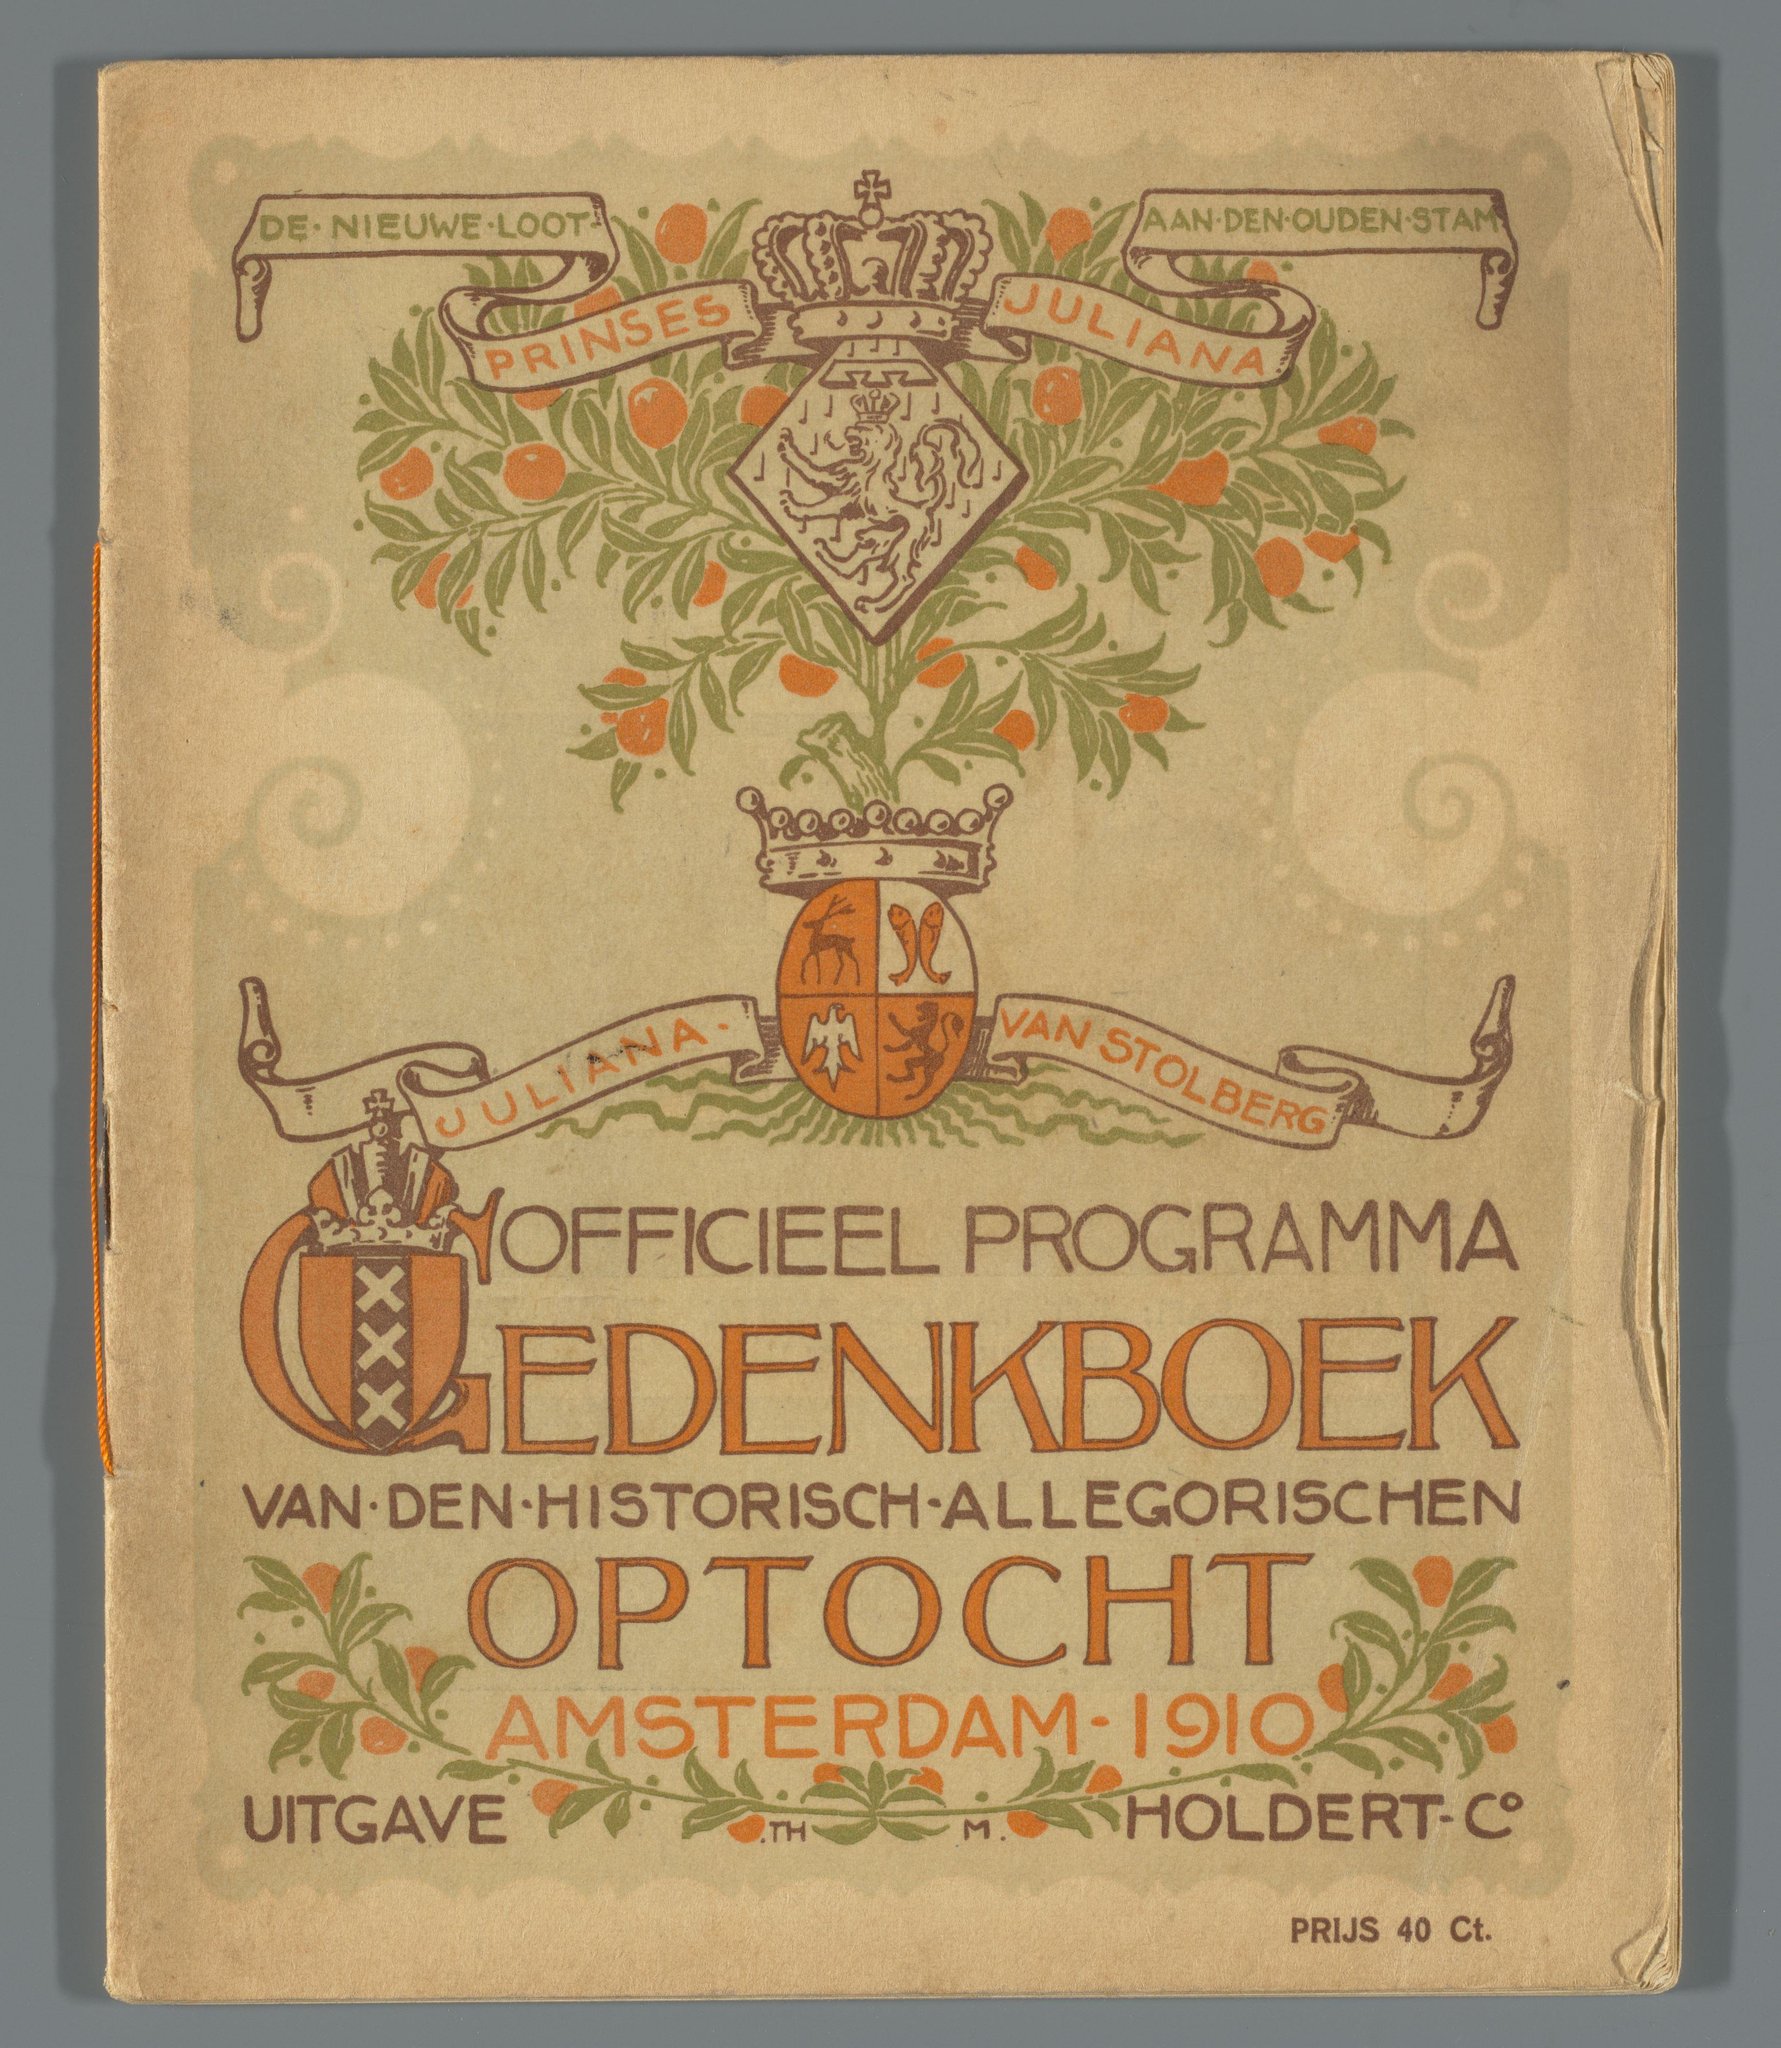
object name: brochure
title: Gedenkboek van den historisch allegorischen optocht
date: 1910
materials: paper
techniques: printing, sewing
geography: amsterdam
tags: amsterdam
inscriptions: date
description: 20 genummerde pp met enkele pp met advertenties in versierde papieren omslag met rood touwtje gebonden. Gedateerd; titelp.: 1910.